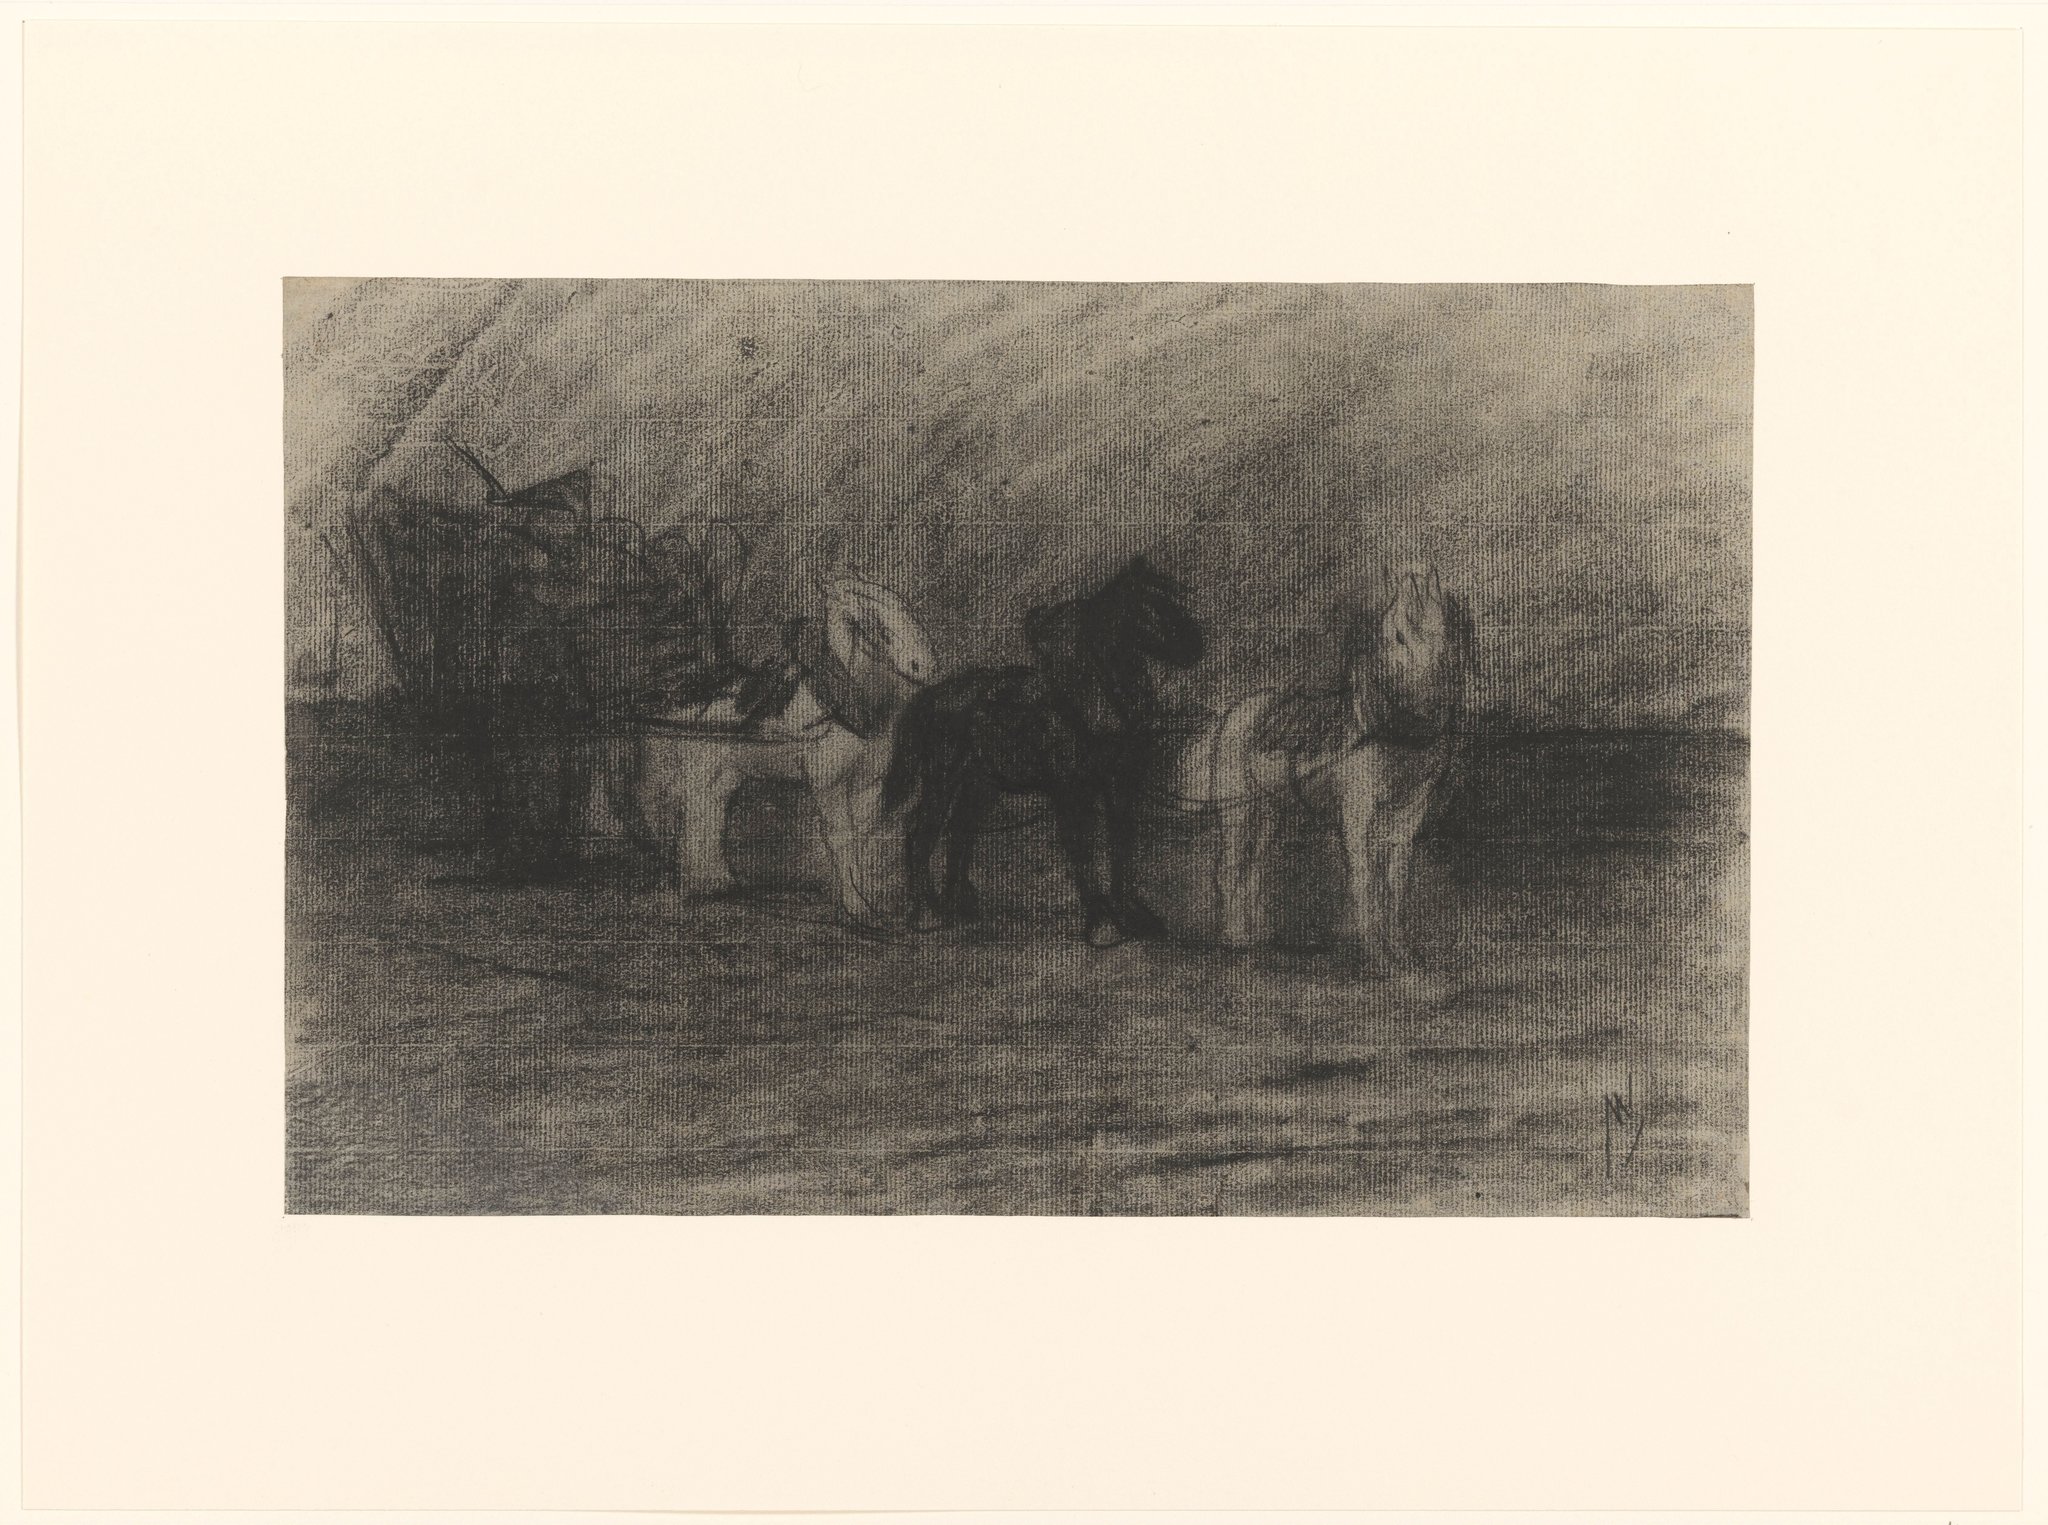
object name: drawing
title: Paarden voor een wagen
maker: maurits van der valk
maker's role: draughtsman, print maker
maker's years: 1857-1935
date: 1867-1935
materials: charcoal, paper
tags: (farm) wagon, freight wagon, cart